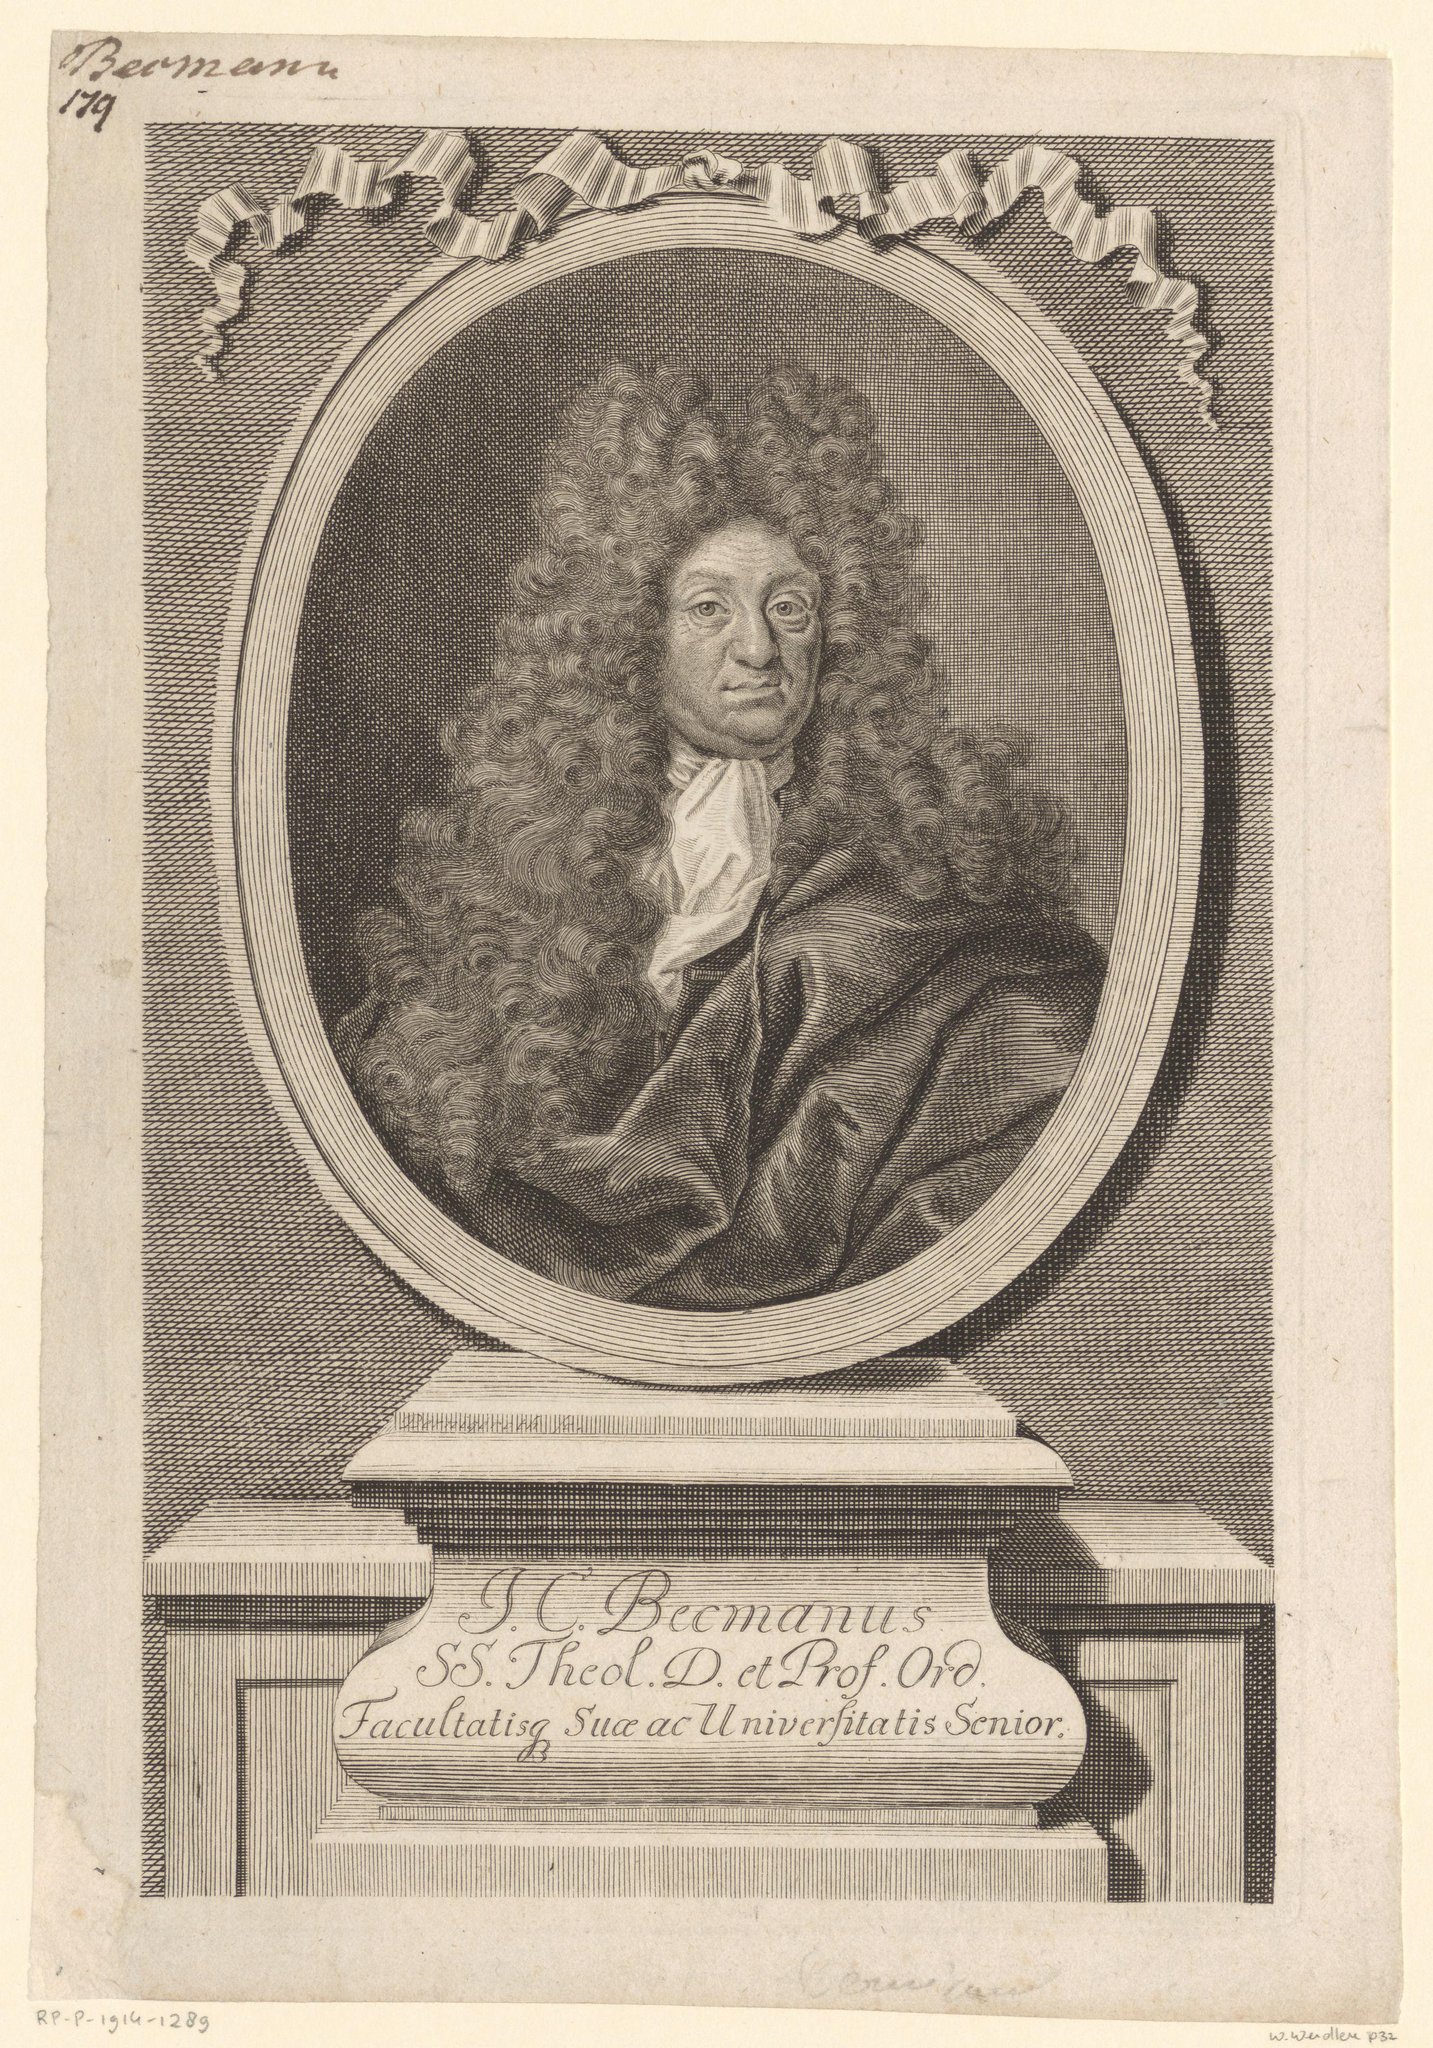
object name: print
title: Portret van Johann Christoph Becmann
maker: martin bernigeroth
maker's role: print maker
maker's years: 1670-1733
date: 1707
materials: paper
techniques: engraving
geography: leipzig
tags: historical persons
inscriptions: collector's mark: Lugt 2228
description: Prent ook gebruikt in: Becmann, Johann Christoph. Notitia Universitatis Francofurtanae (...) 1707. [Frankfurt an der Oder: Schrey & Hartmann, 1707].